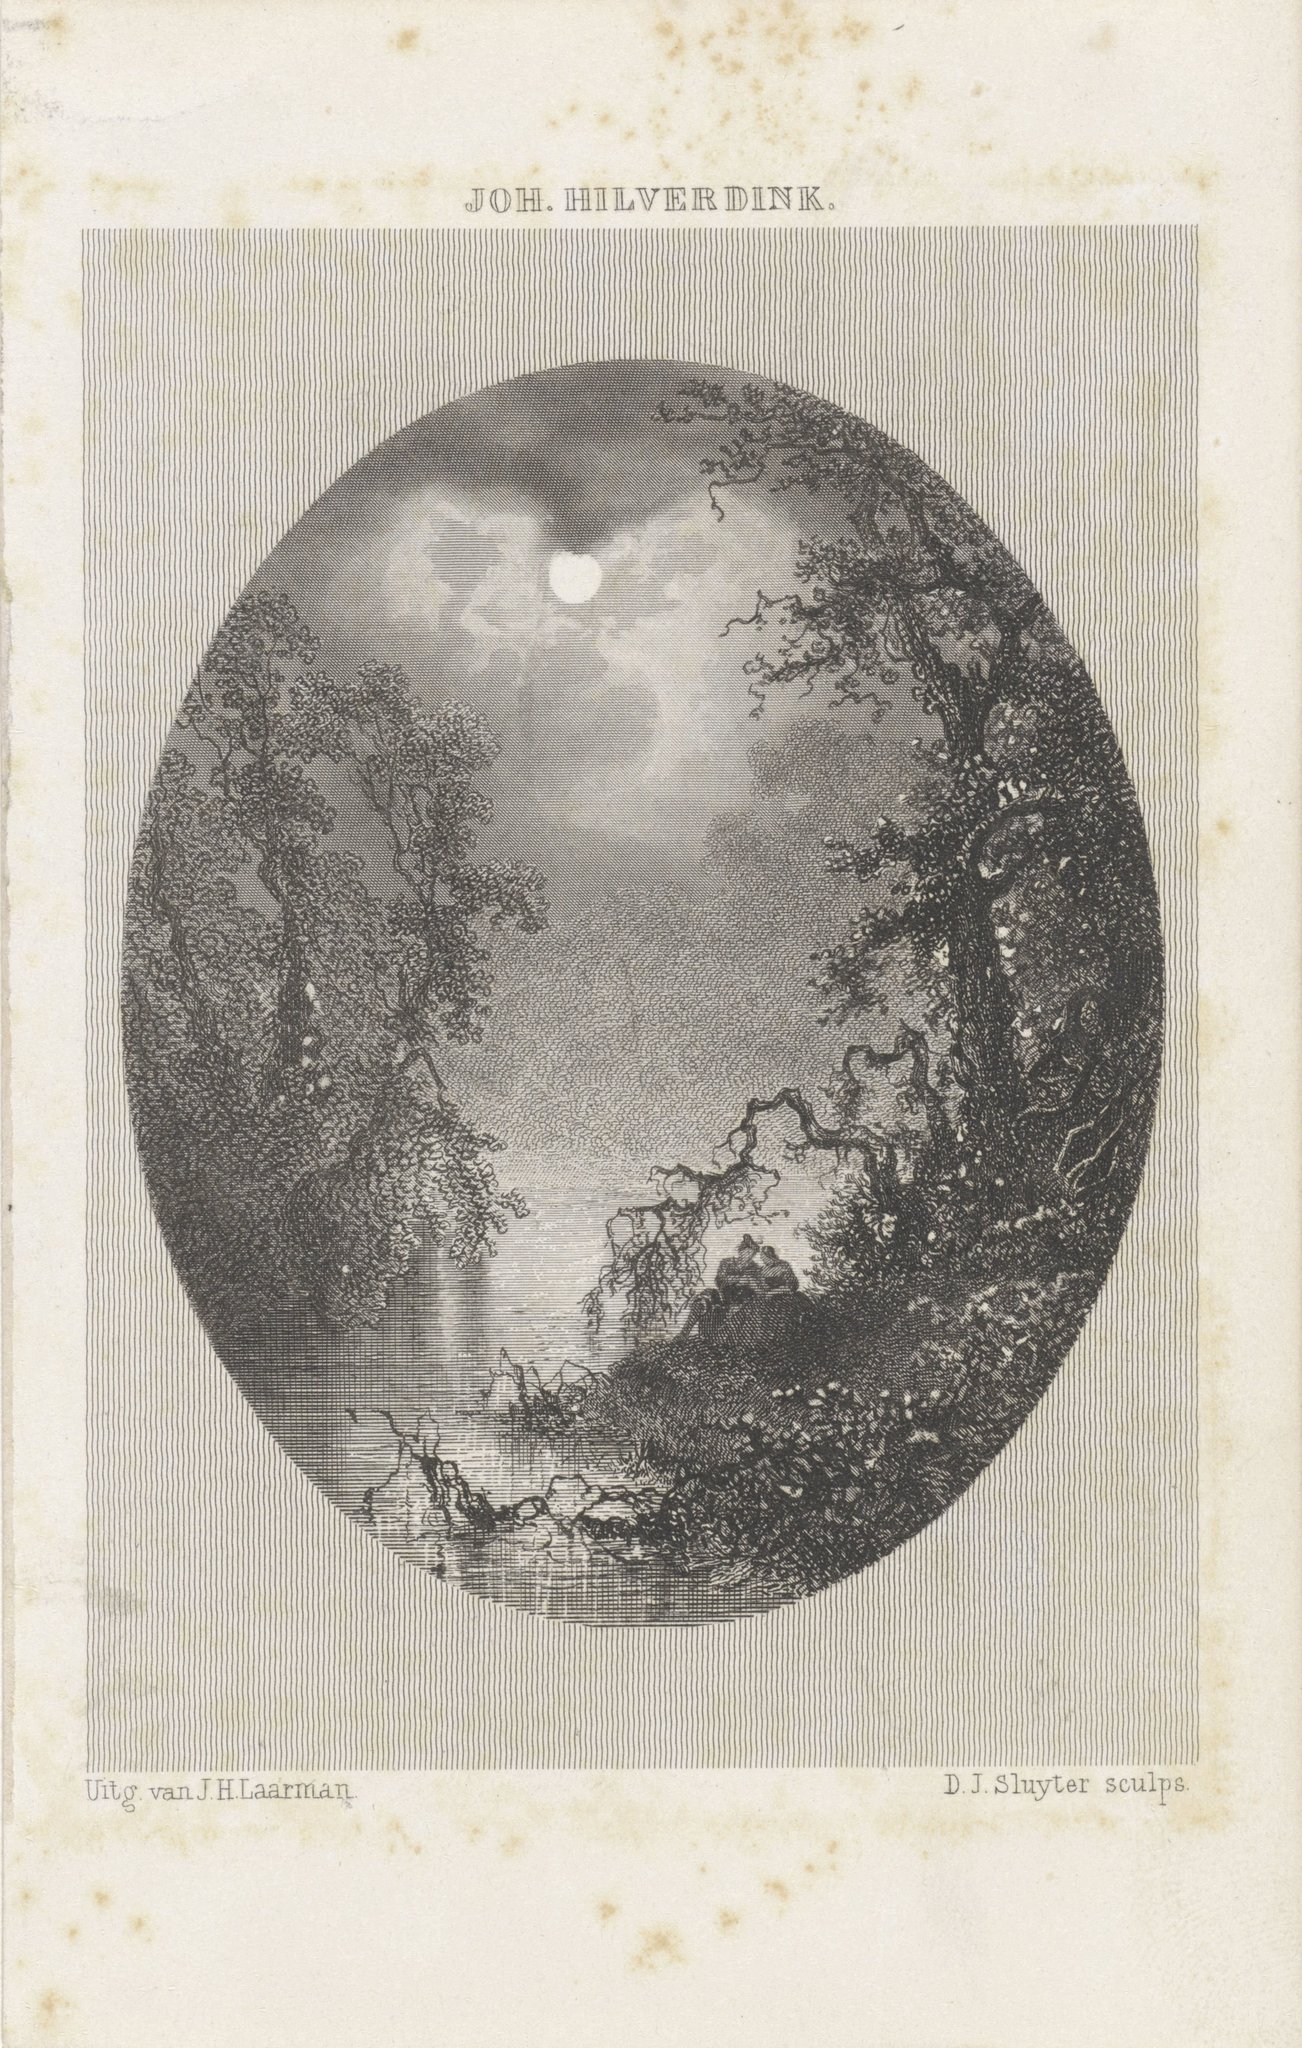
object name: print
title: Landschap bij nacht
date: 1870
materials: paper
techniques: engraving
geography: amsterdam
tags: night ~ landscape (sometimes titled 'nox'), couple of lovers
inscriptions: collector's mark: Lugt 2228, inscription: ‘Uit Aurora 1870’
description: Een volle maan beschijnt een rivier waarlangs hoge bomen staan. Op de oever zitten een man en een vrouw die elkaar bij de hand houden.